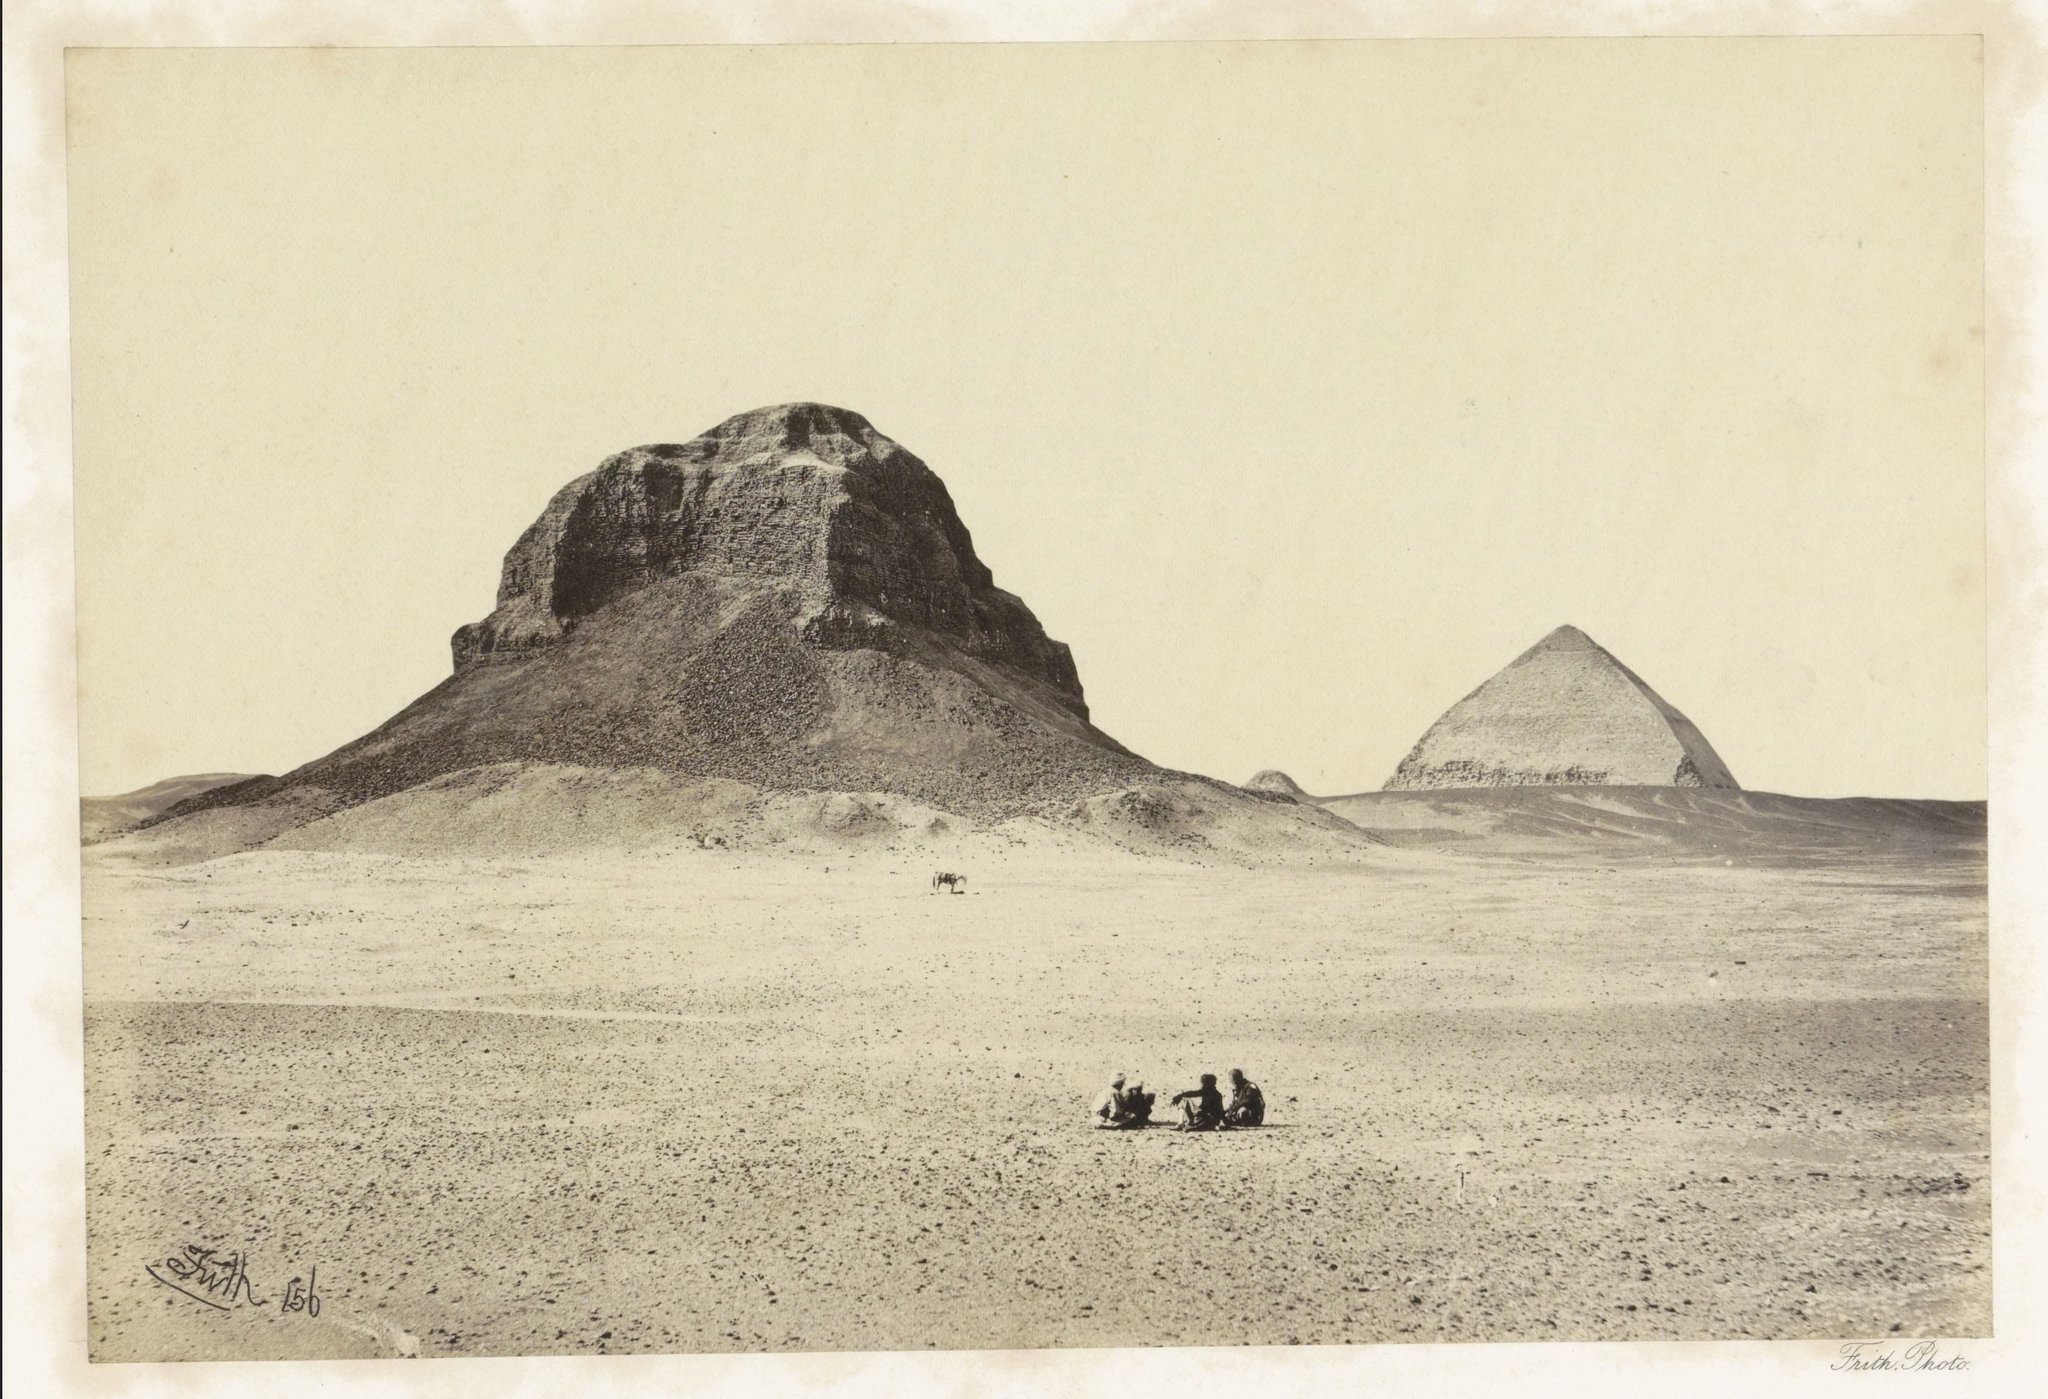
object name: photograph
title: Piramides van Dasjoer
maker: francis frith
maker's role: publisher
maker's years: 1822-1898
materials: paper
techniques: albumen print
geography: dasjoer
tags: egyptian pyramids (wonder of the world)